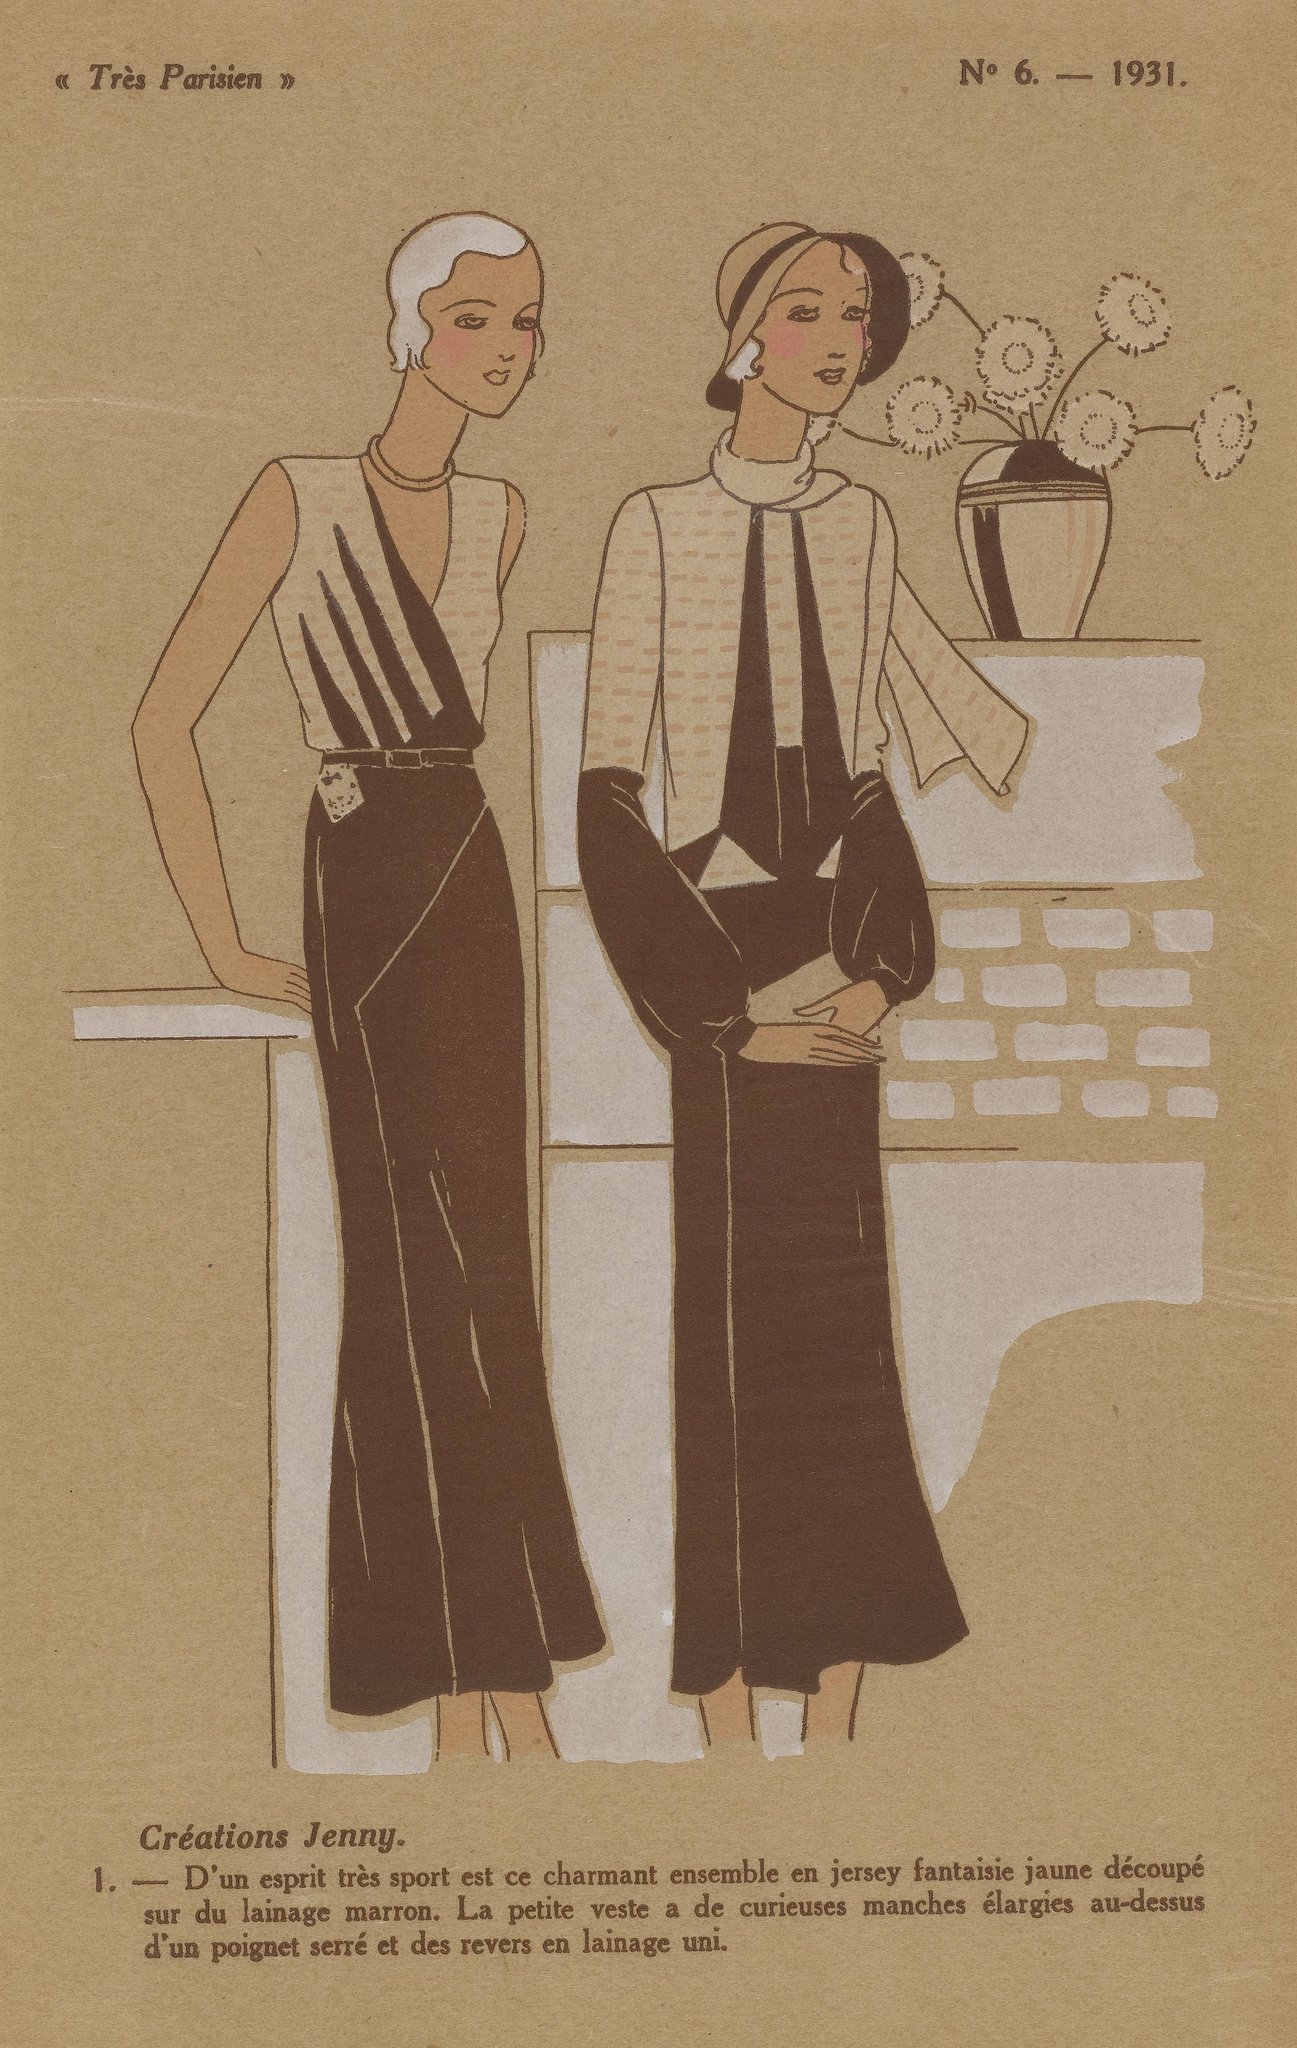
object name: fashion print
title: Très Parisien, 1931, No. 6 : Créations Jenny. / 1. - D'un esprit très sport....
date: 1931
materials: paper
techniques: hand coloring, letterpress printing, lithography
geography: paris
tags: neck-gear ~ clothing (revers) (+ women's clothes), coat (+ women's clothes), head-gear: hat (+ women's clothes), dress, gown (+ women's clothes), flowers in a vase, sleeves (+ women's clothes)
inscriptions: caption: ‘1. Créations Jenny. / 1.- D'un esprit très sport est ce charmant ensemble en jersey fantaisie jaune découpé sur du lainage marron. La petite veste a de curieuses manches élargies au-dessus d'un poignet serré et des revers en lainage uni.’, title: ‘"Très Parisien"/ No 6. - 1931’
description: Ontwerpen van modehuis Jenny. Ensemble van gele 'jersey fantaisie' en bruine wol. Jas met bijzondere mouwen: gladde bovenmouw en poffende ondermouw. Revers van effen wol. Prent uit het modetijdschrift Très Parisien (1920-1936).